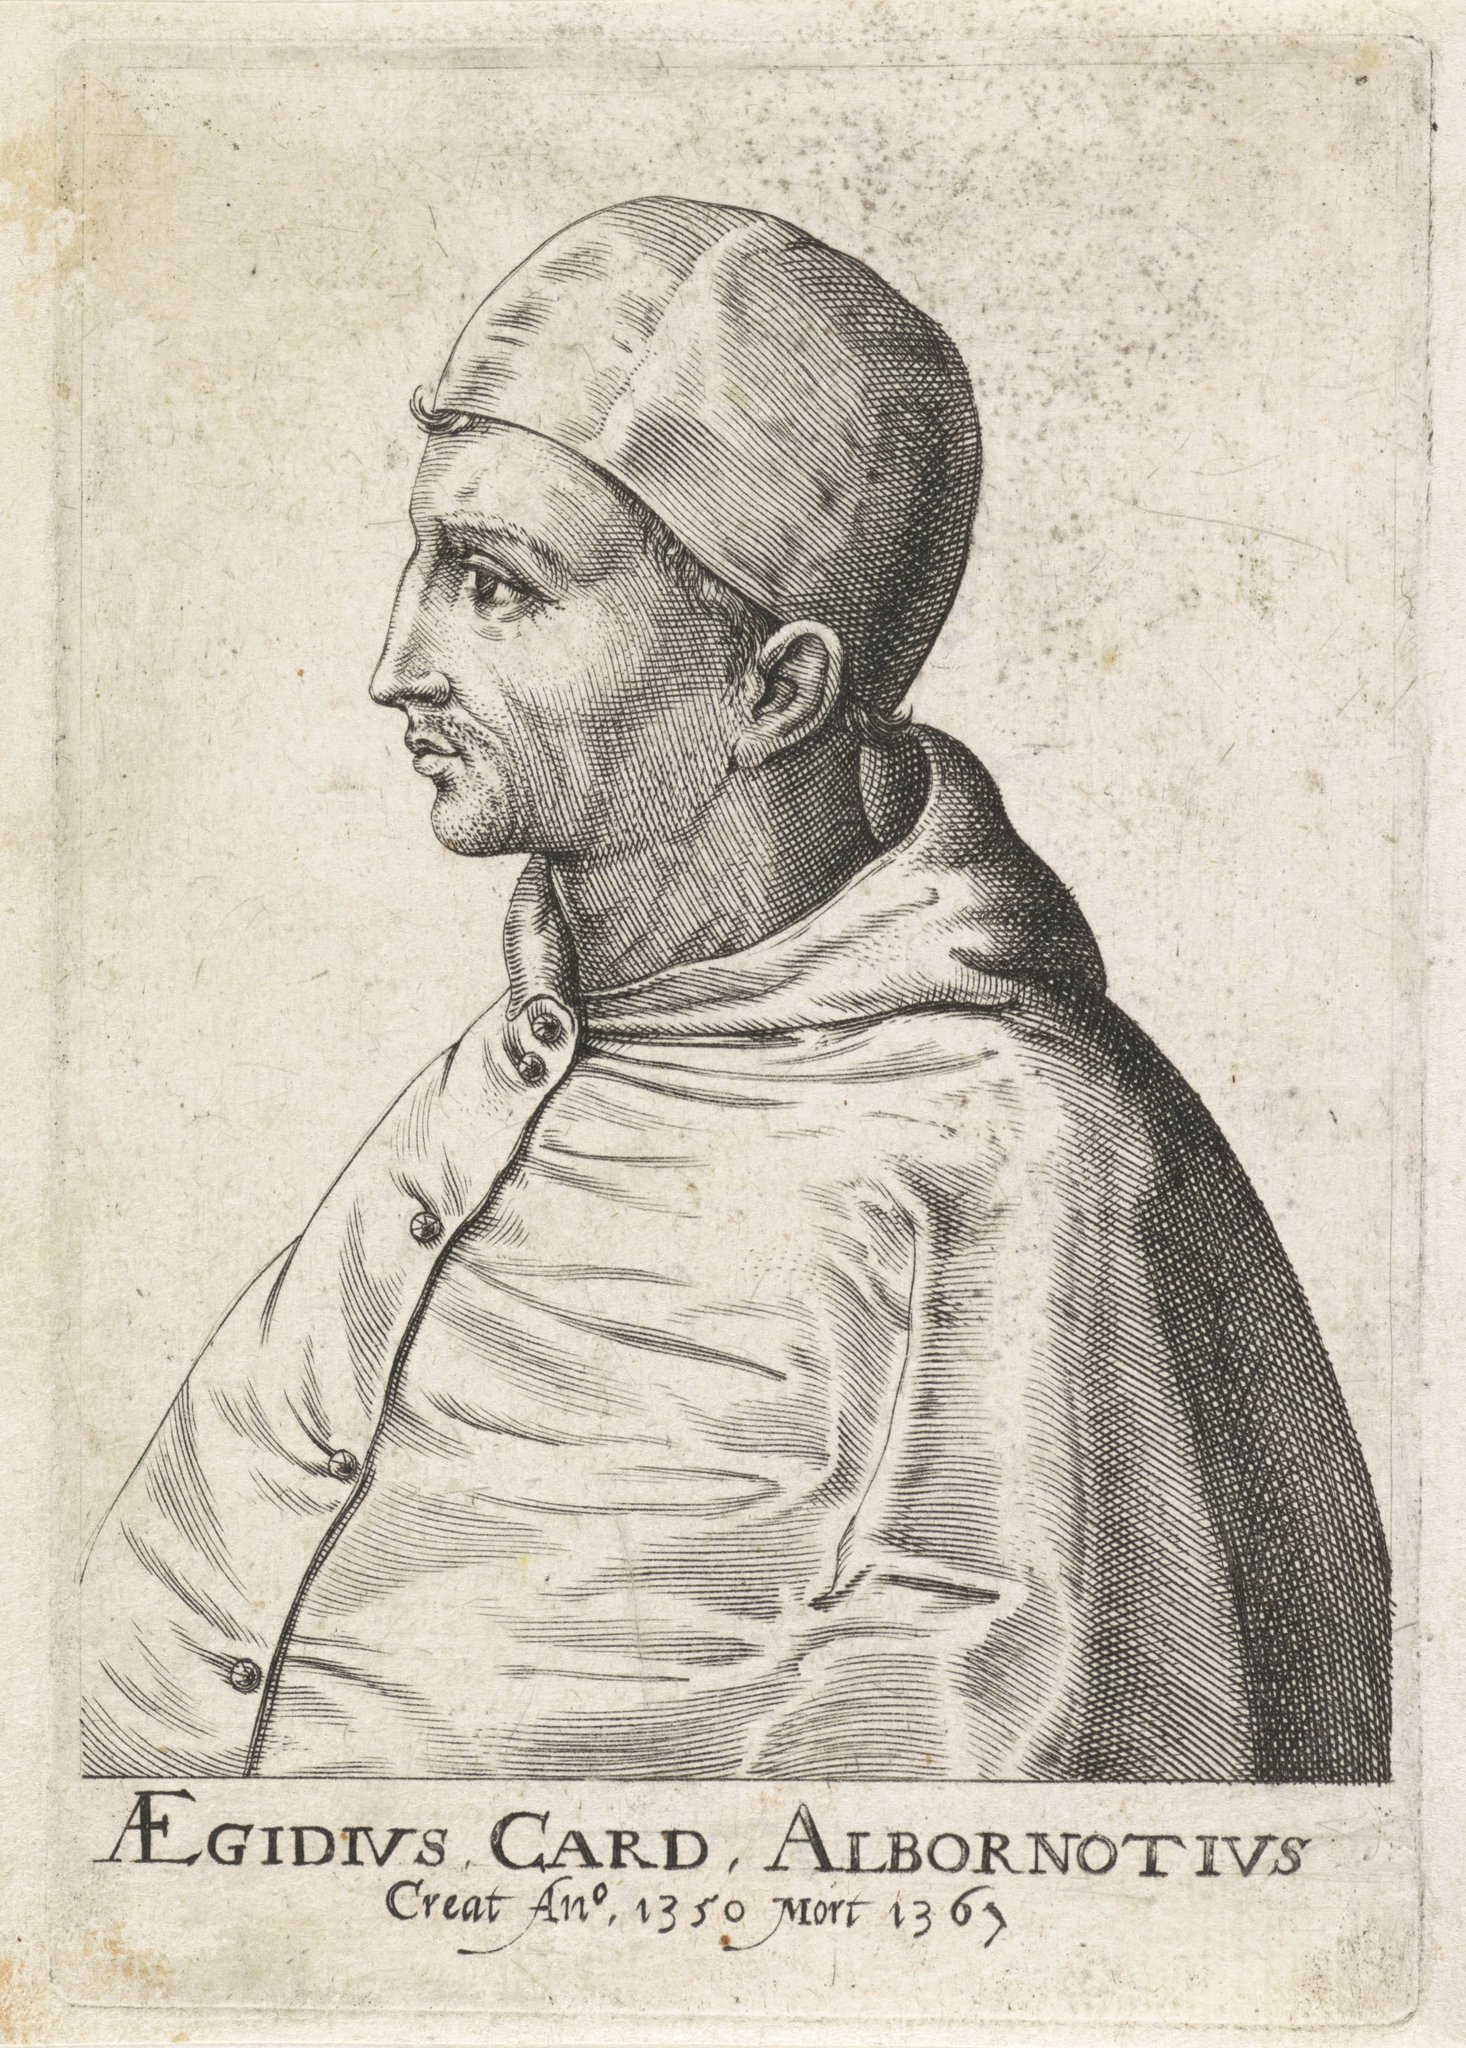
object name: print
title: Ægidivs Card. Albornotivs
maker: frans van den wijngaerde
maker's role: print maker, publisher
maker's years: 1614-1679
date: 1644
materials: paper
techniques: engraving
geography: antwerp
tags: cardinal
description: Prent gebruikt in: Albi, Henri. Eloges historiques des Cardinaux illustres François et etrangers mis en parallele. Parijs: Anthoine de Cay, 1644.